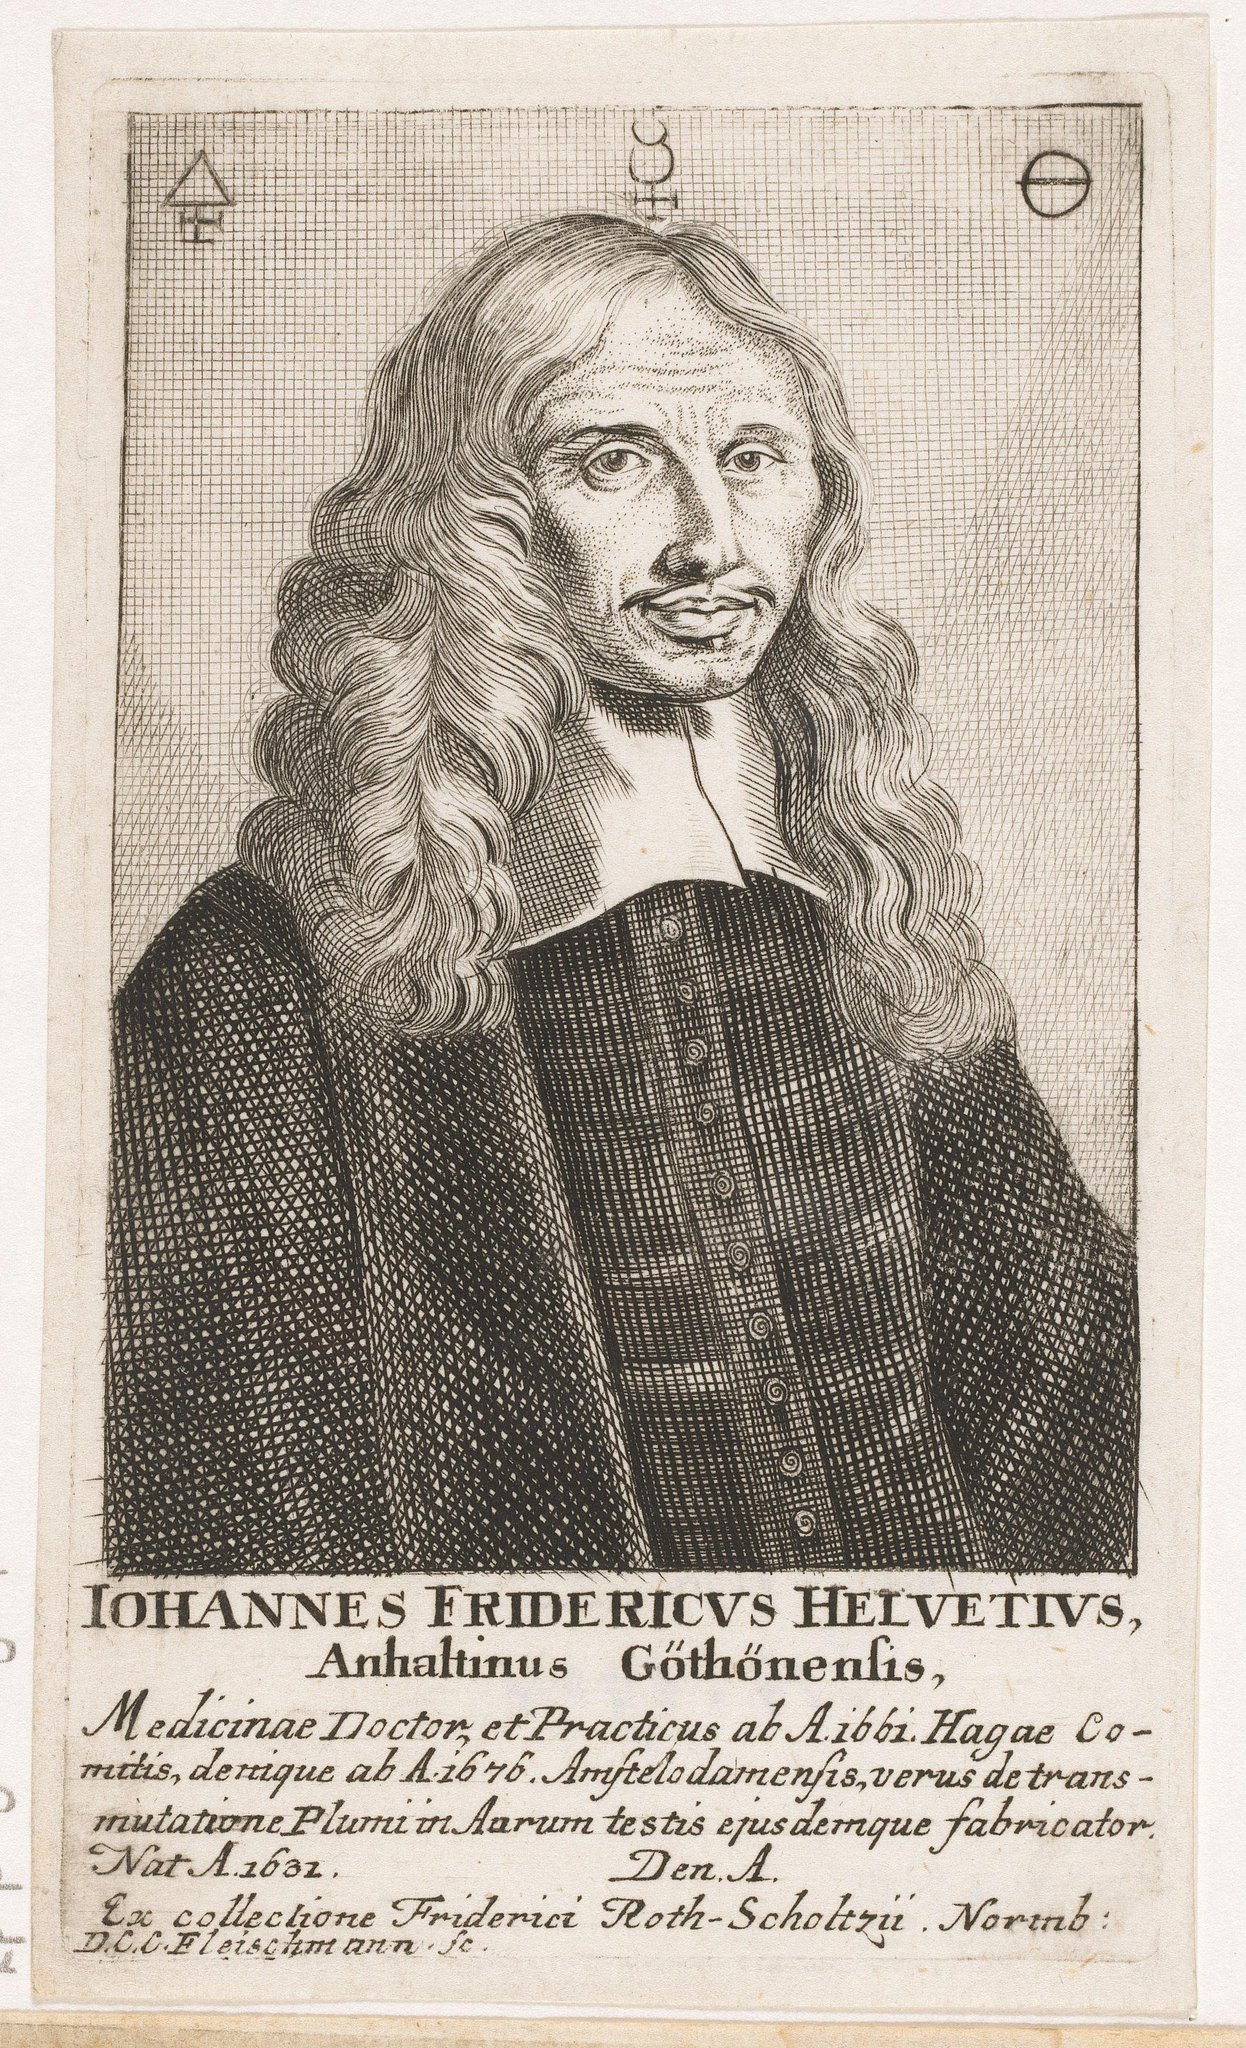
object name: print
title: Portret van Johann Friedrich Helvetius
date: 1690-1732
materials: paper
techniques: engraving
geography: nuremberg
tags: alchemistic symbols, historical persons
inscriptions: collector's mark: Lugt 2228